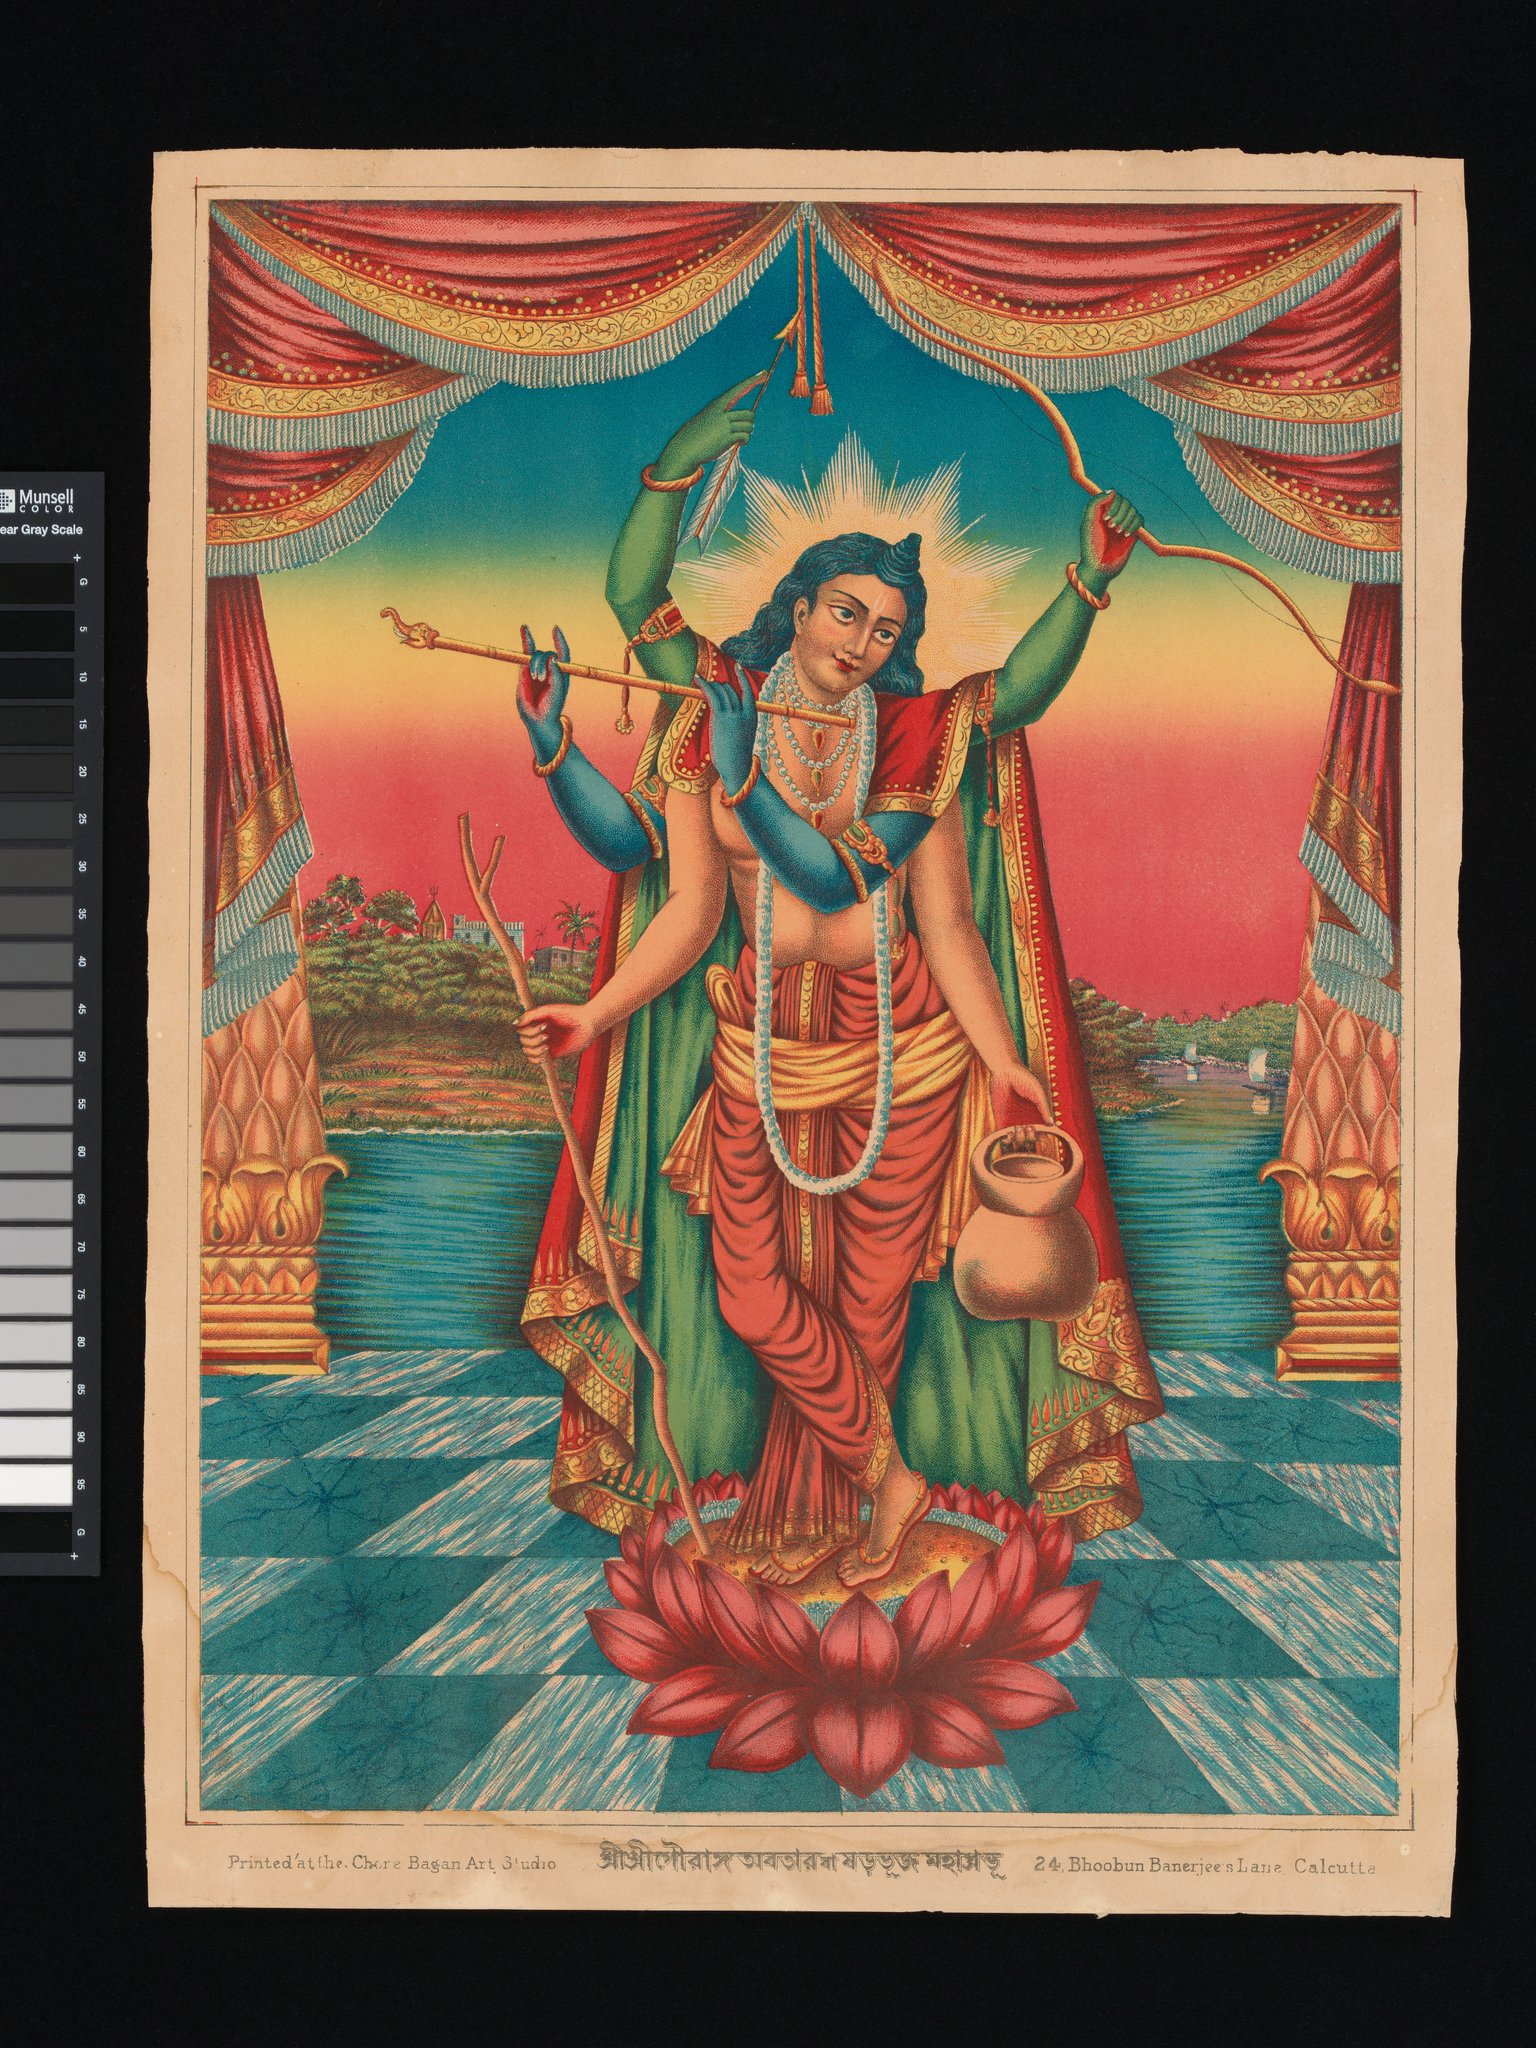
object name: print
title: Shri Shri Guranga Avatara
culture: indian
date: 1895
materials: chromolithograph, paper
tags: bow and arrow,flutes,krishna